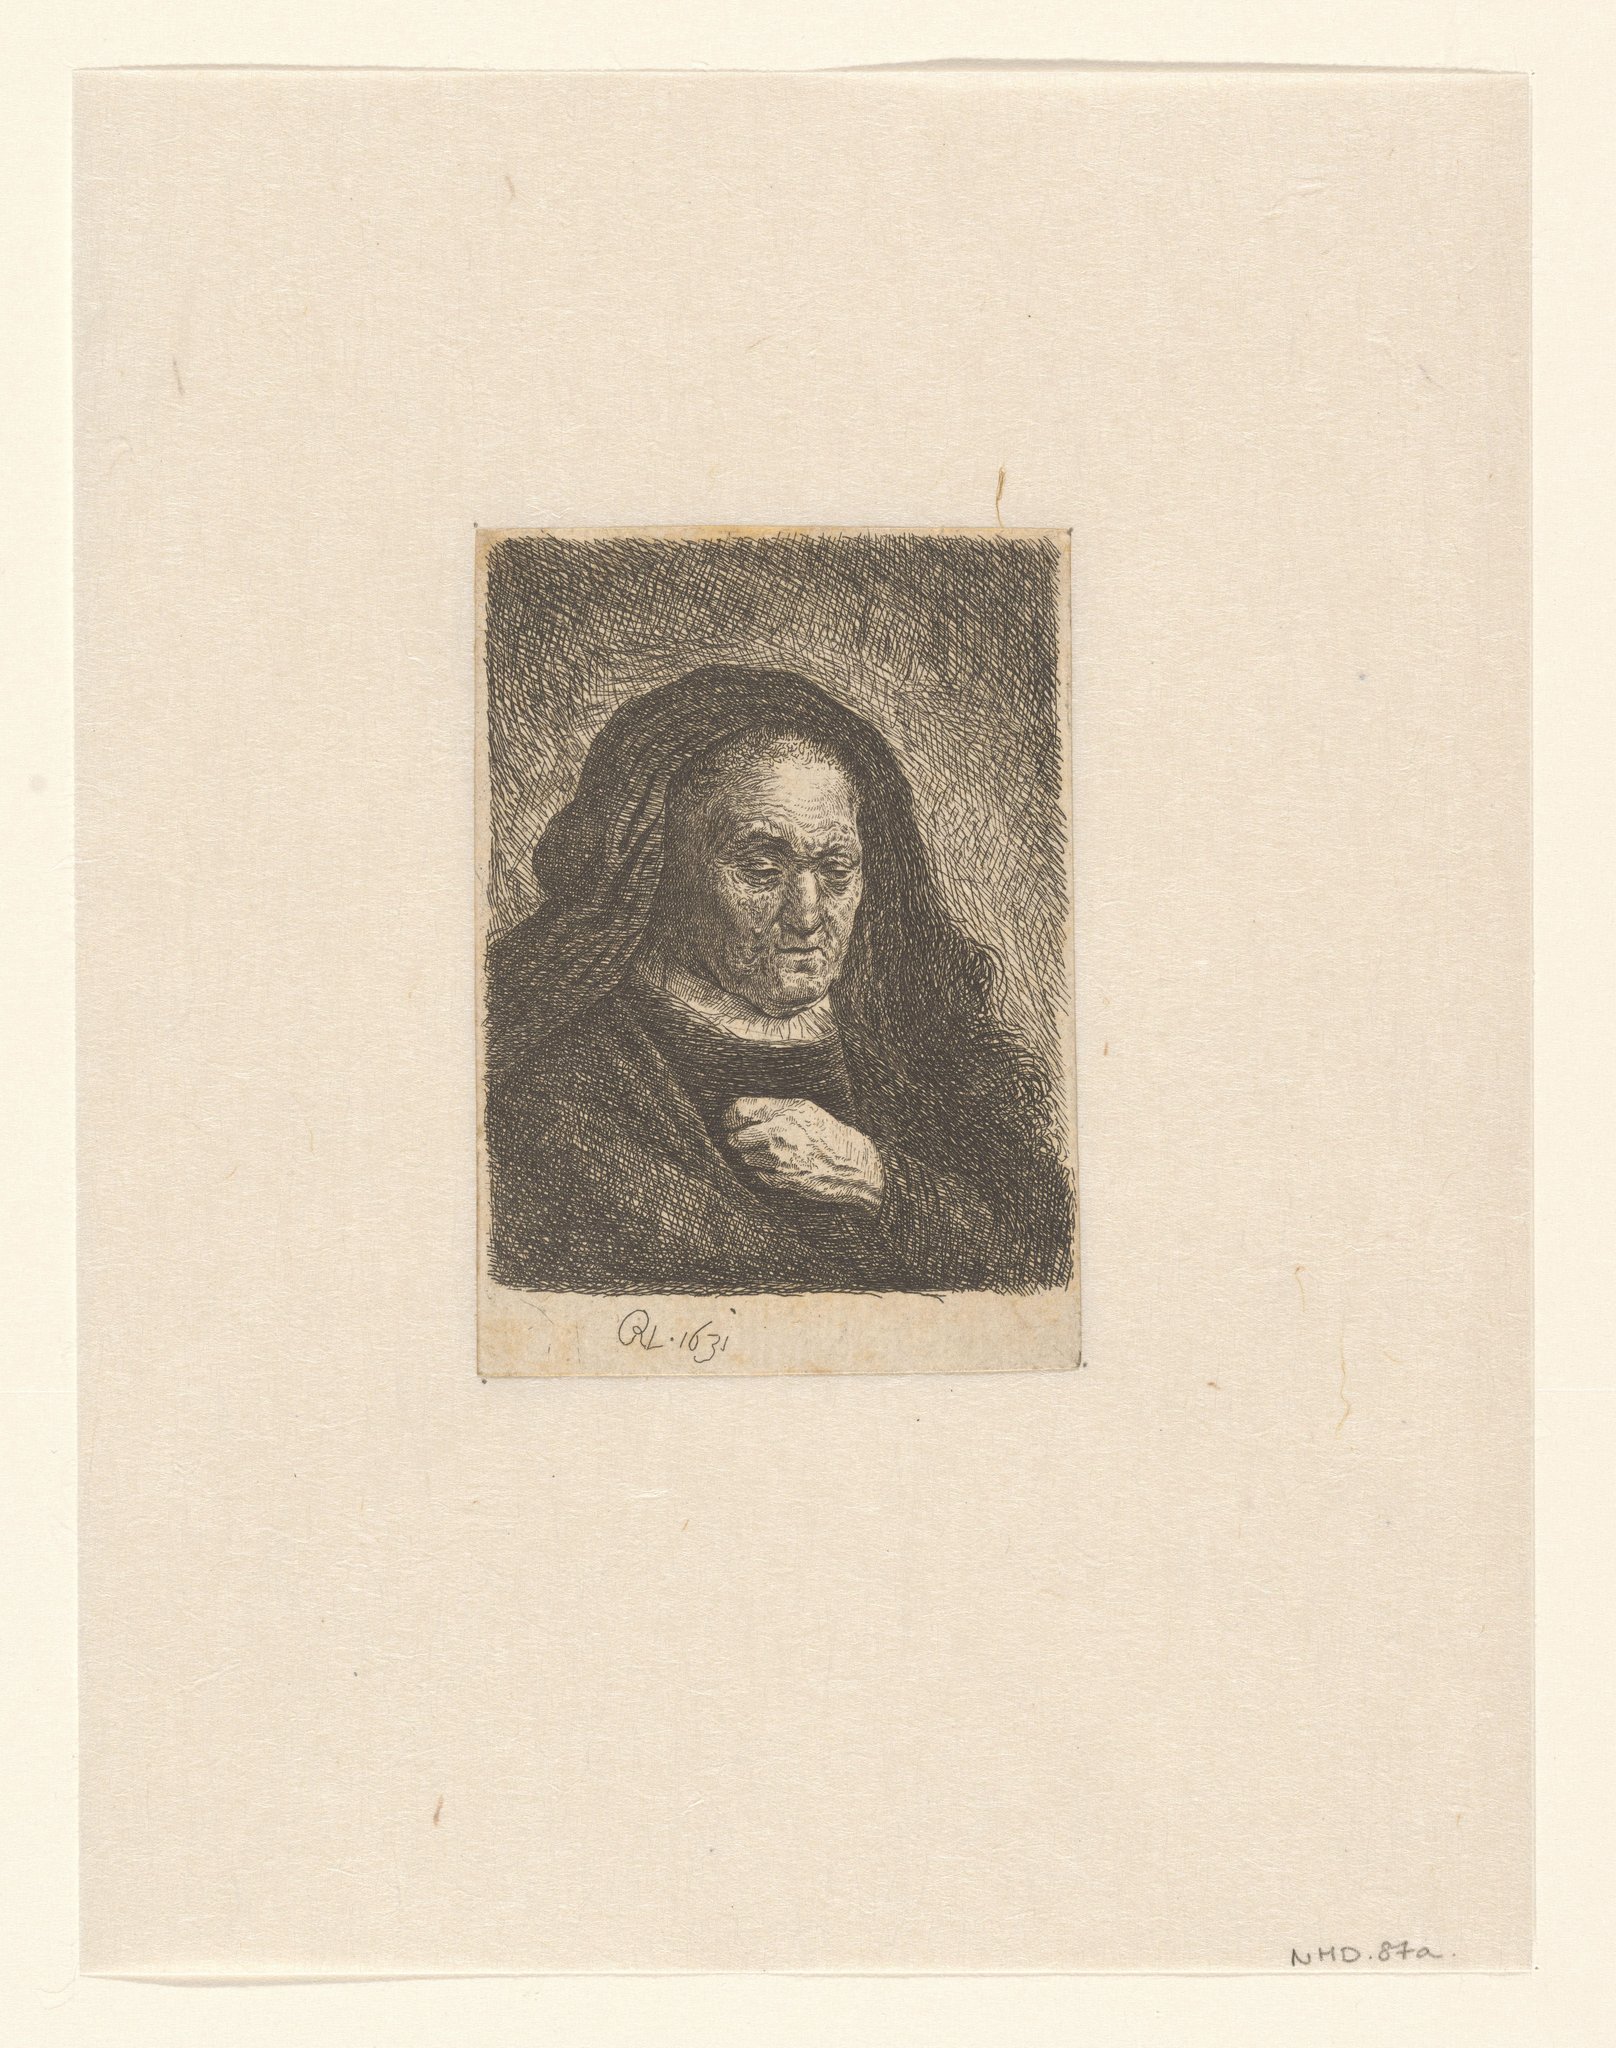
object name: print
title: The artist's mother with her hand on her chest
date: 1631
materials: paper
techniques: etching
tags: historical persons - bb - woman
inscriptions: stamp, collector's mark: Lugt 2228, collector's mark: Lugt 2760